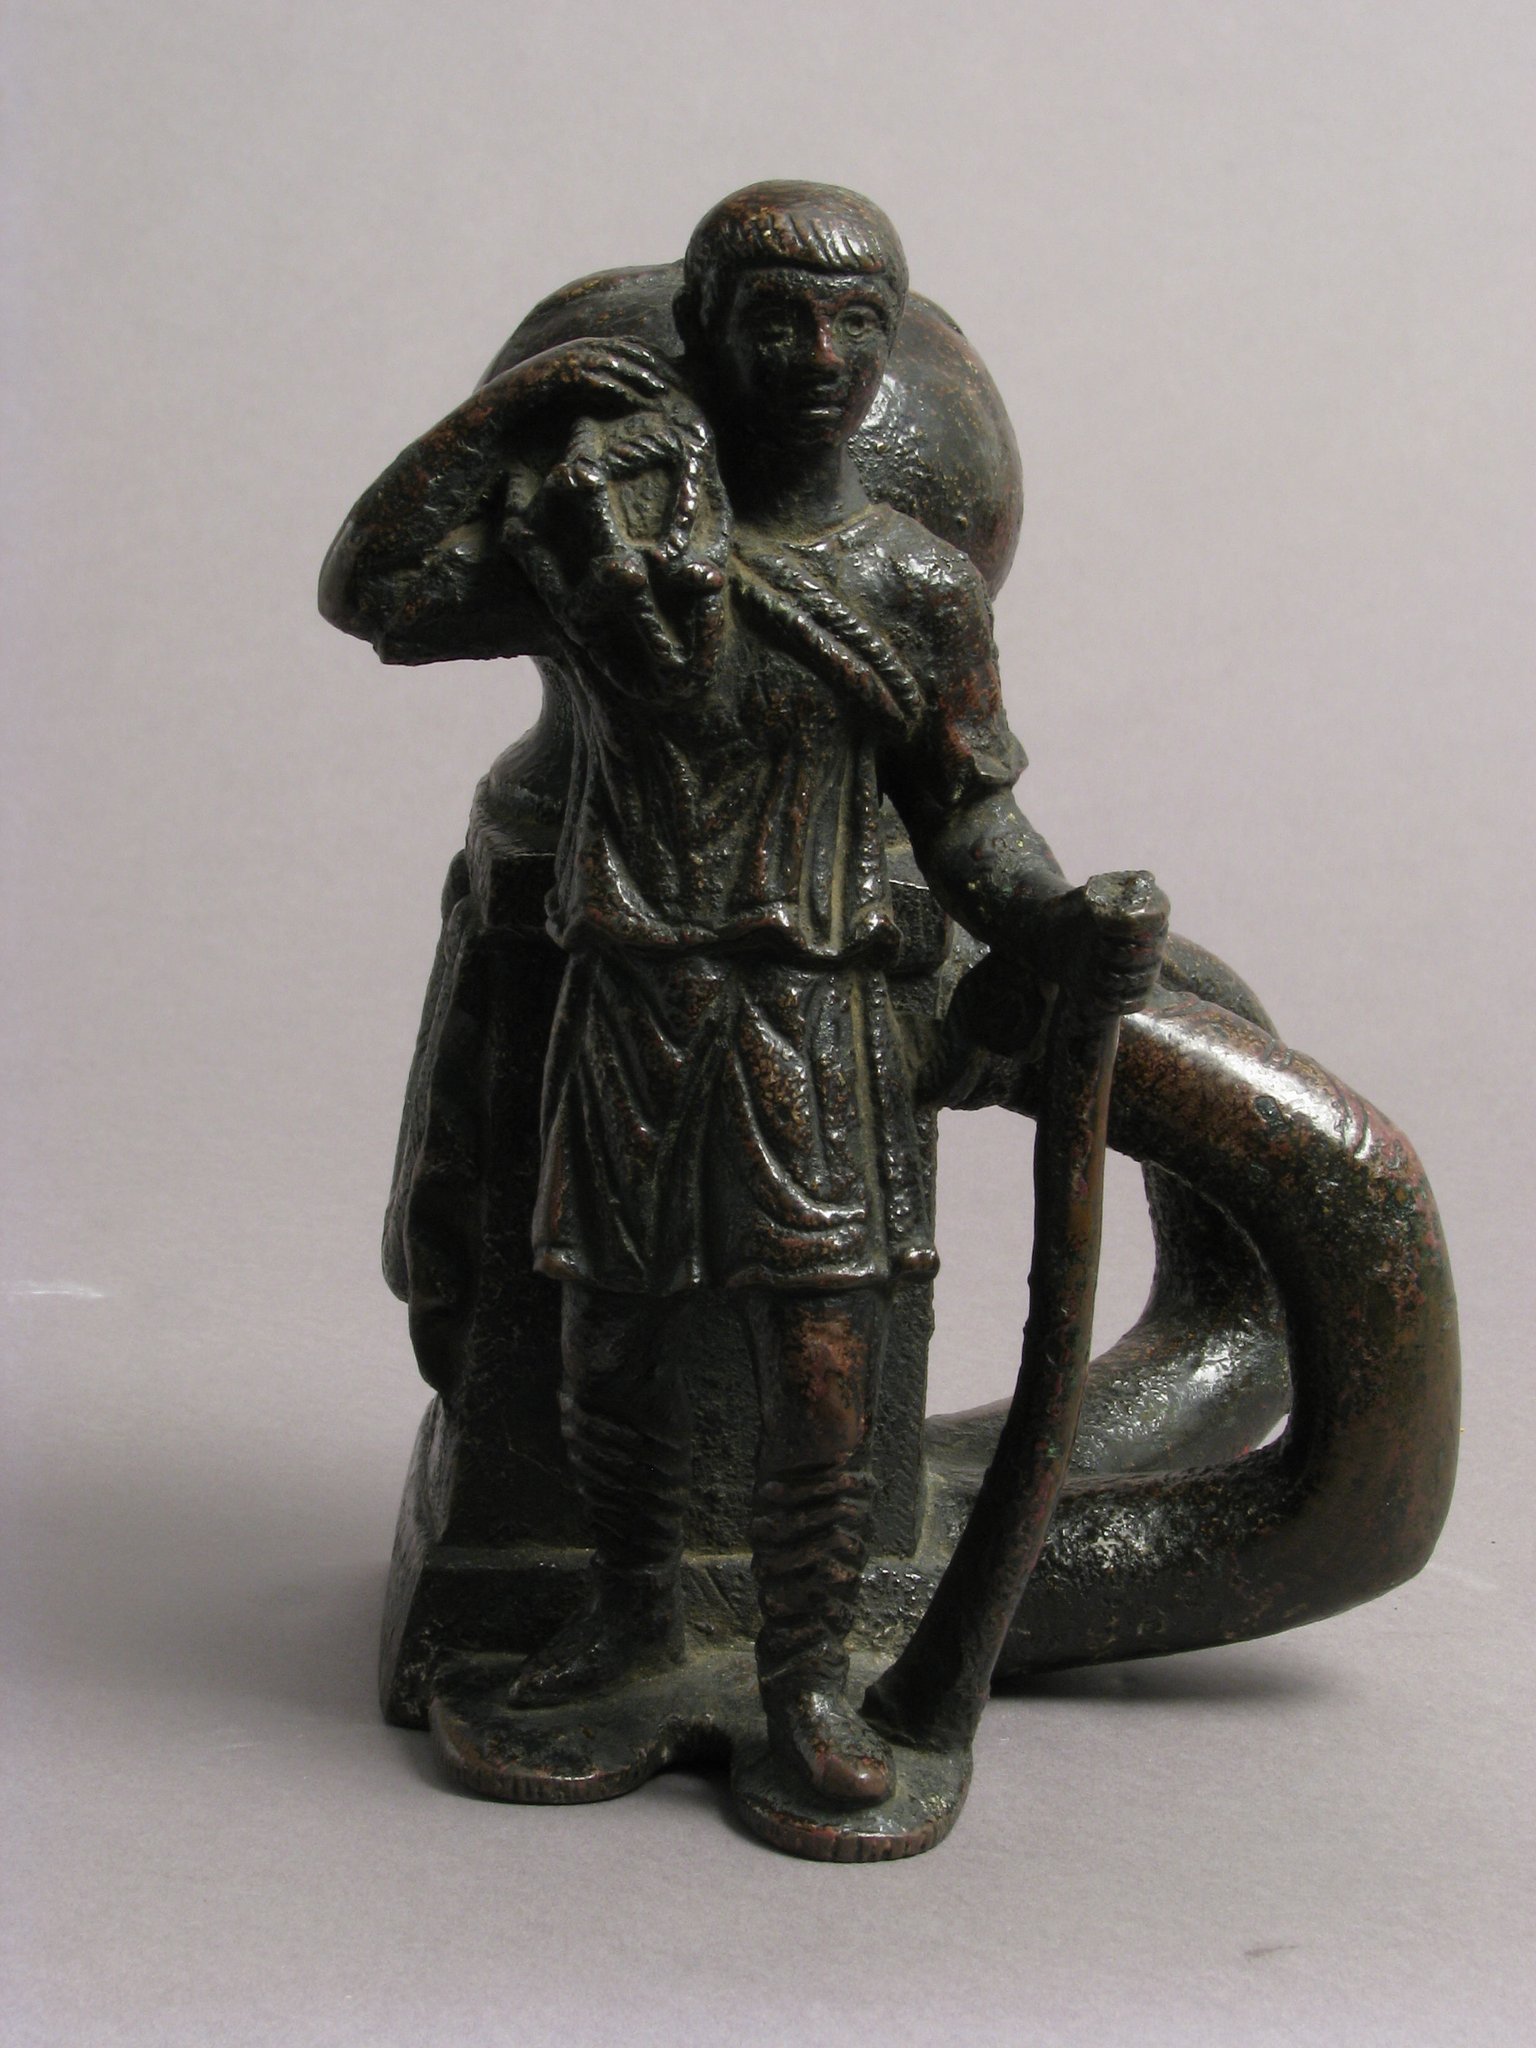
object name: ship mount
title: Bollard with a Fisherman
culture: late roman or byzantine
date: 401-433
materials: bronze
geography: italy